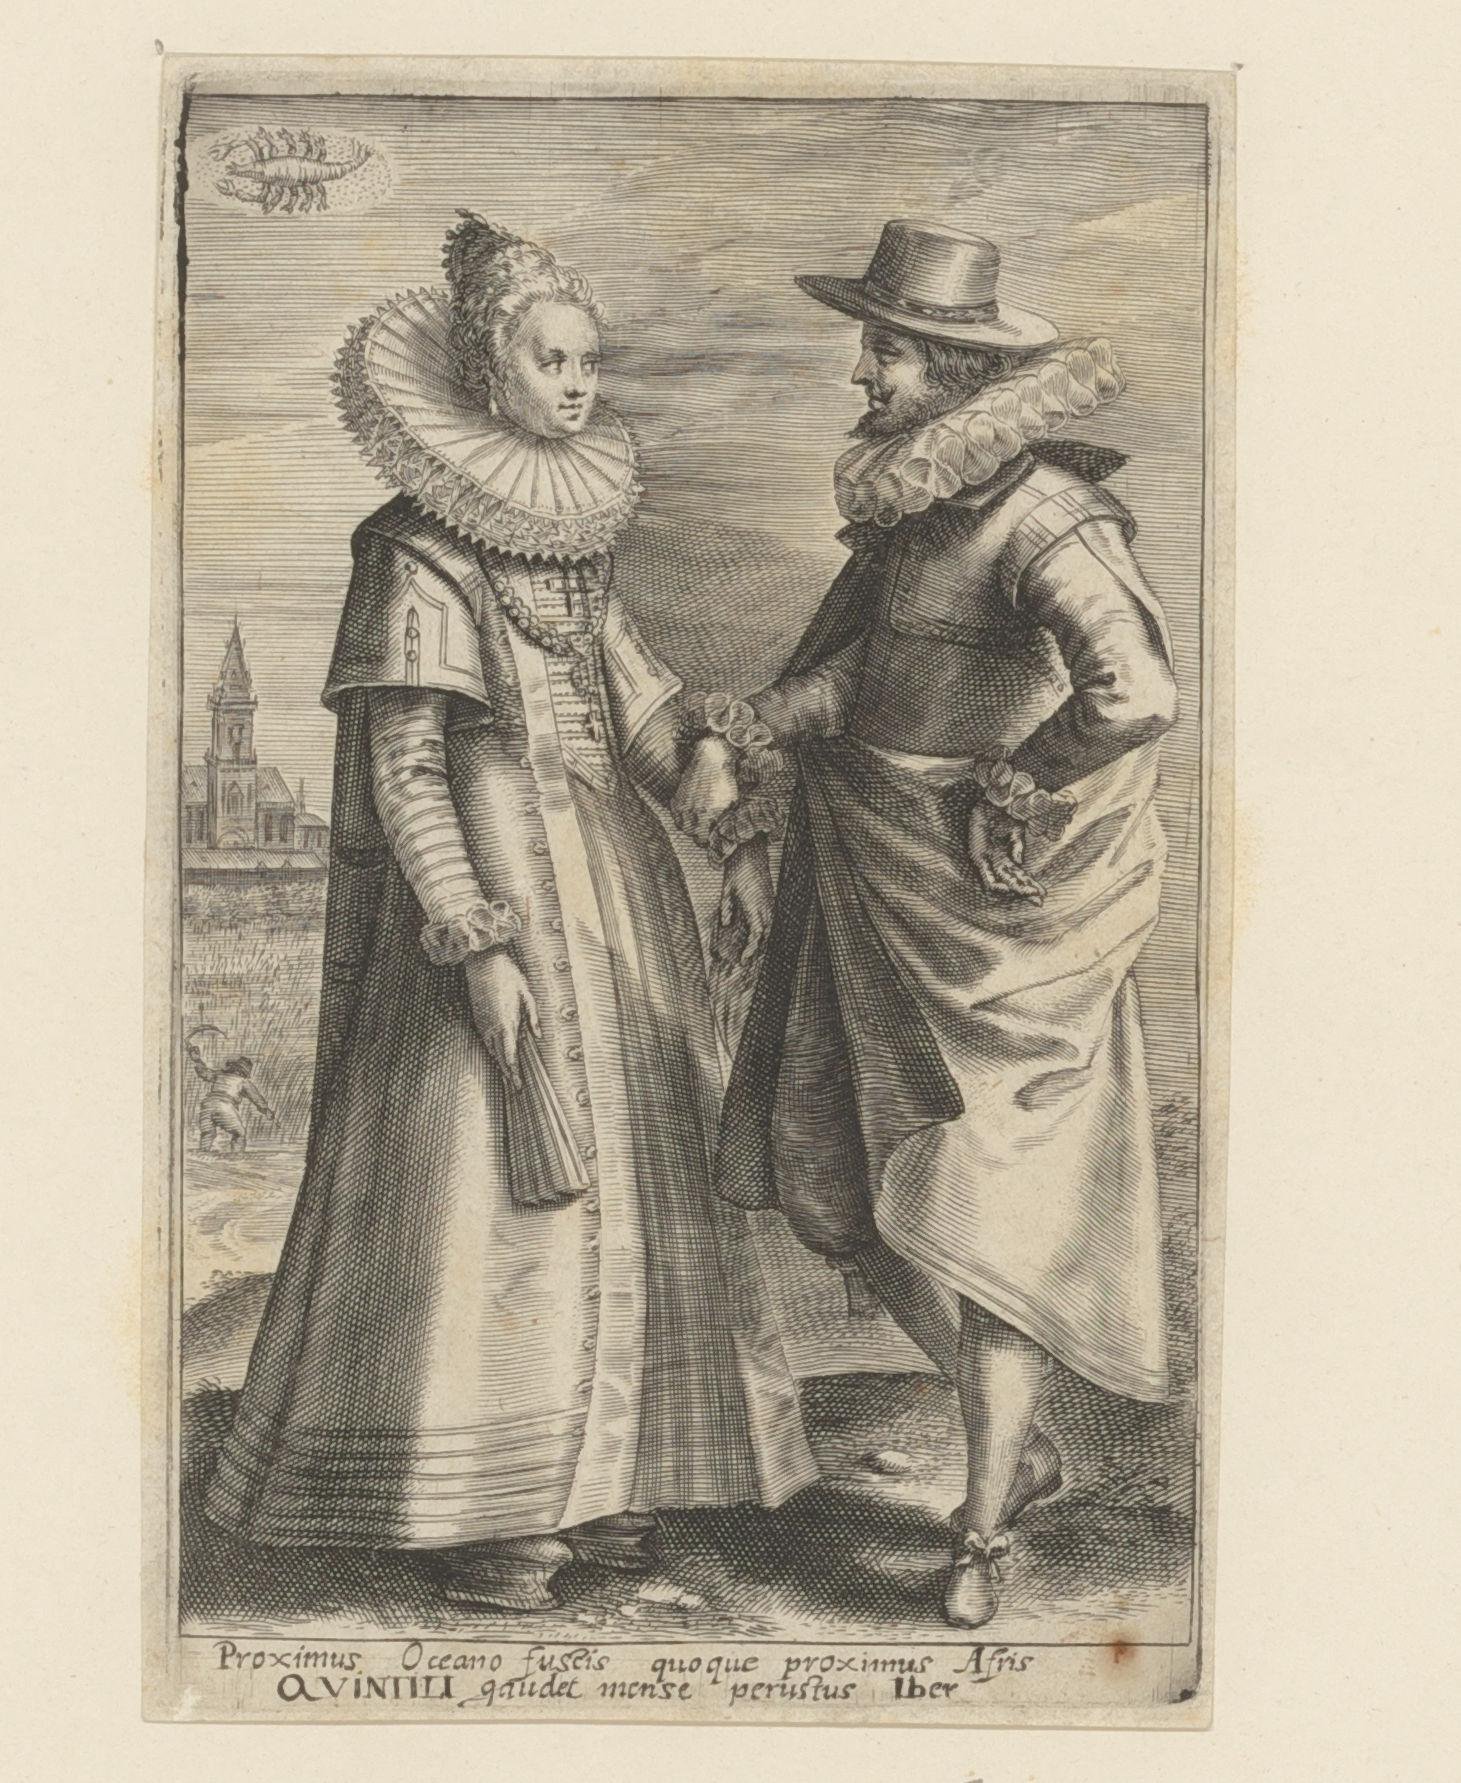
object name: print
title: Juni: een paar uit Spanje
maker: crispijn van de passe (ii)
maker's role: draughtsman, print maker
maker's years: 1594-1670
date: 1613-1670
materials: paper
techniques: engraving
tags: cancer (zodiacal sign of june), europeans: spaniards (+ costume), coat (+ men's clothes), dress, gown (vlieger) (+ women's clothes), head-gear: hat (+ men's clothes), head-gear: cap (+ women's clothes), clothes, costume (+ women's clothes), neck-gear ~ clothing (with name) (+ women's clothes), clothes, costume (+ men's clothes), shoes, sandals, june ~ other concepts, spain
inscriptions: collector's mark: Lugt 963, collector's mark: Lugt 1641, stamp:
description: Man en vrouw uit Spanje, gekleed volgens de mode van ca. 1620: beiden met een brede plooikraag. Op de achtergrond een kerktoren en hooioogst. Linksboven het teken van het sterrenbeeld kreeft. In de marge een tweeregelig onderschrift in het Latijn over de ligging van Spanje vlakbij Afrika en de hitte in de maand juni. Prent uit een serie met de twaalf maanden weergegeven door tekens van de dierenriem en paren die kleding uit verschillende landen dragen. Onderwerpsrubrieken binnen de Atlas Zeden en Gewoonten: Zeden en Gewoonten in Engeren Zin, De Kleeding, Kleederdrachten (tijdvakken), Het begin der 17de eeuw. (De Fransche mode).